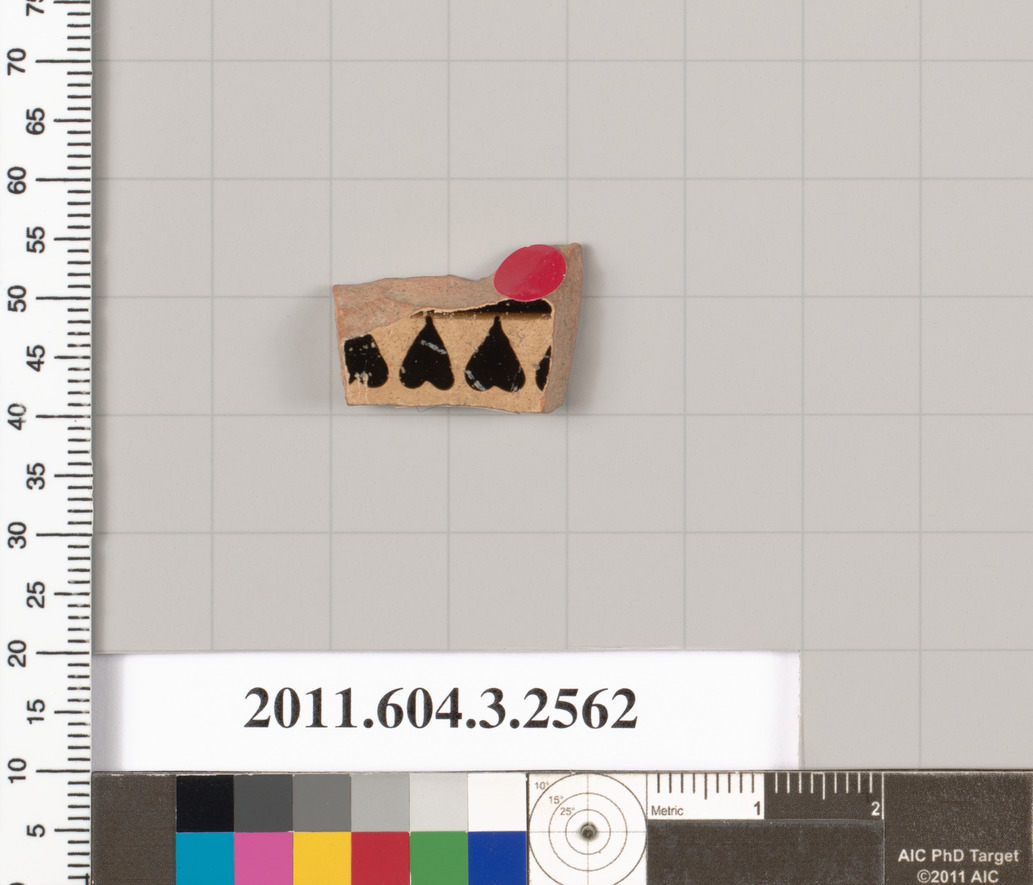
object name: kylix fragment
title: Terracotta fragment of a kylix (drinking cup)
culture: greek, attic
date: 534-468 BCE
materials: terracotta